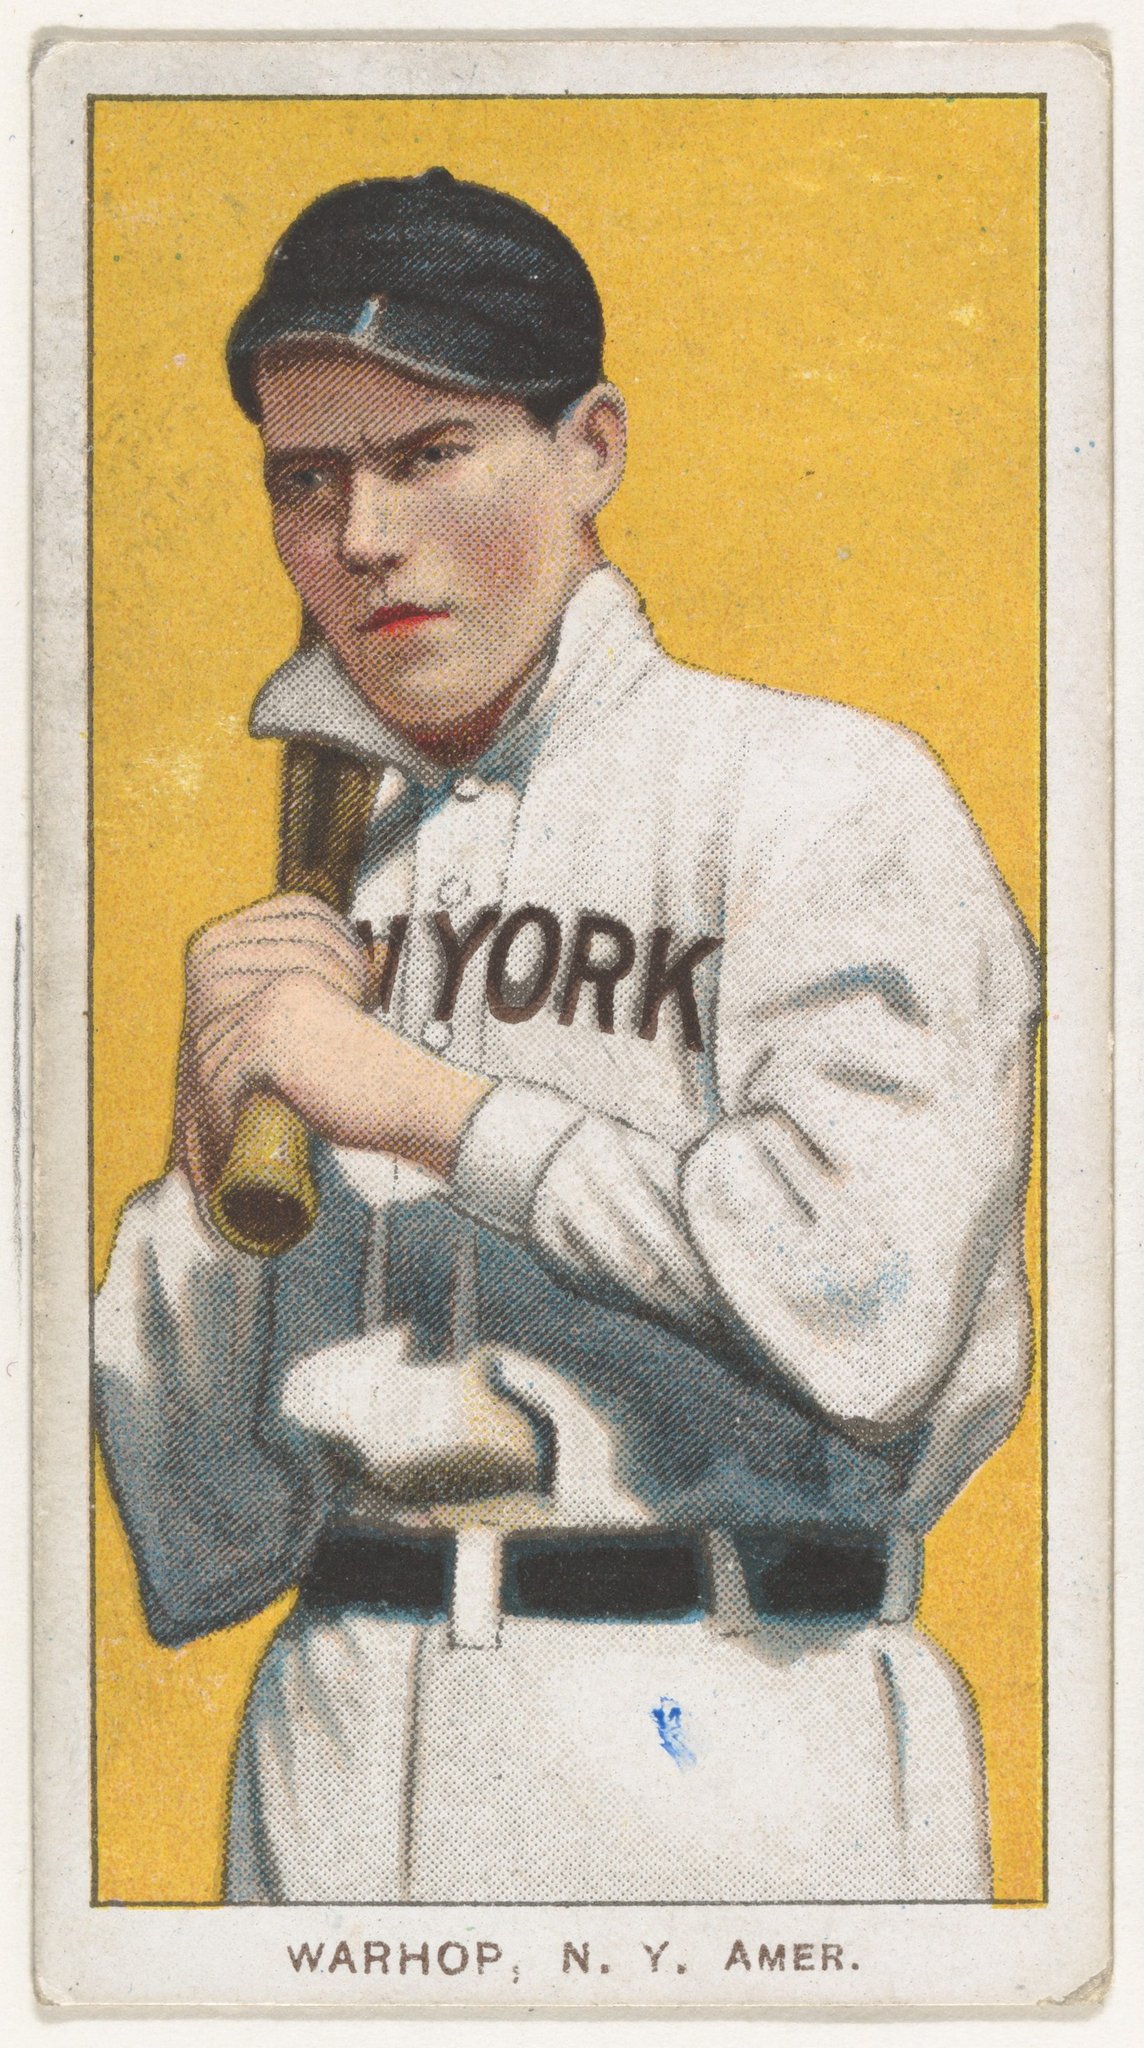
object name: baseball card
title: Warhop, New York, American League, from the White Border series (T206) for the American Tobacco Company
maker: american tobacco company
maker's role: publisher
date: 1909-1911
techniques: color lithograph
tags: men,portraits,baseball,athletes